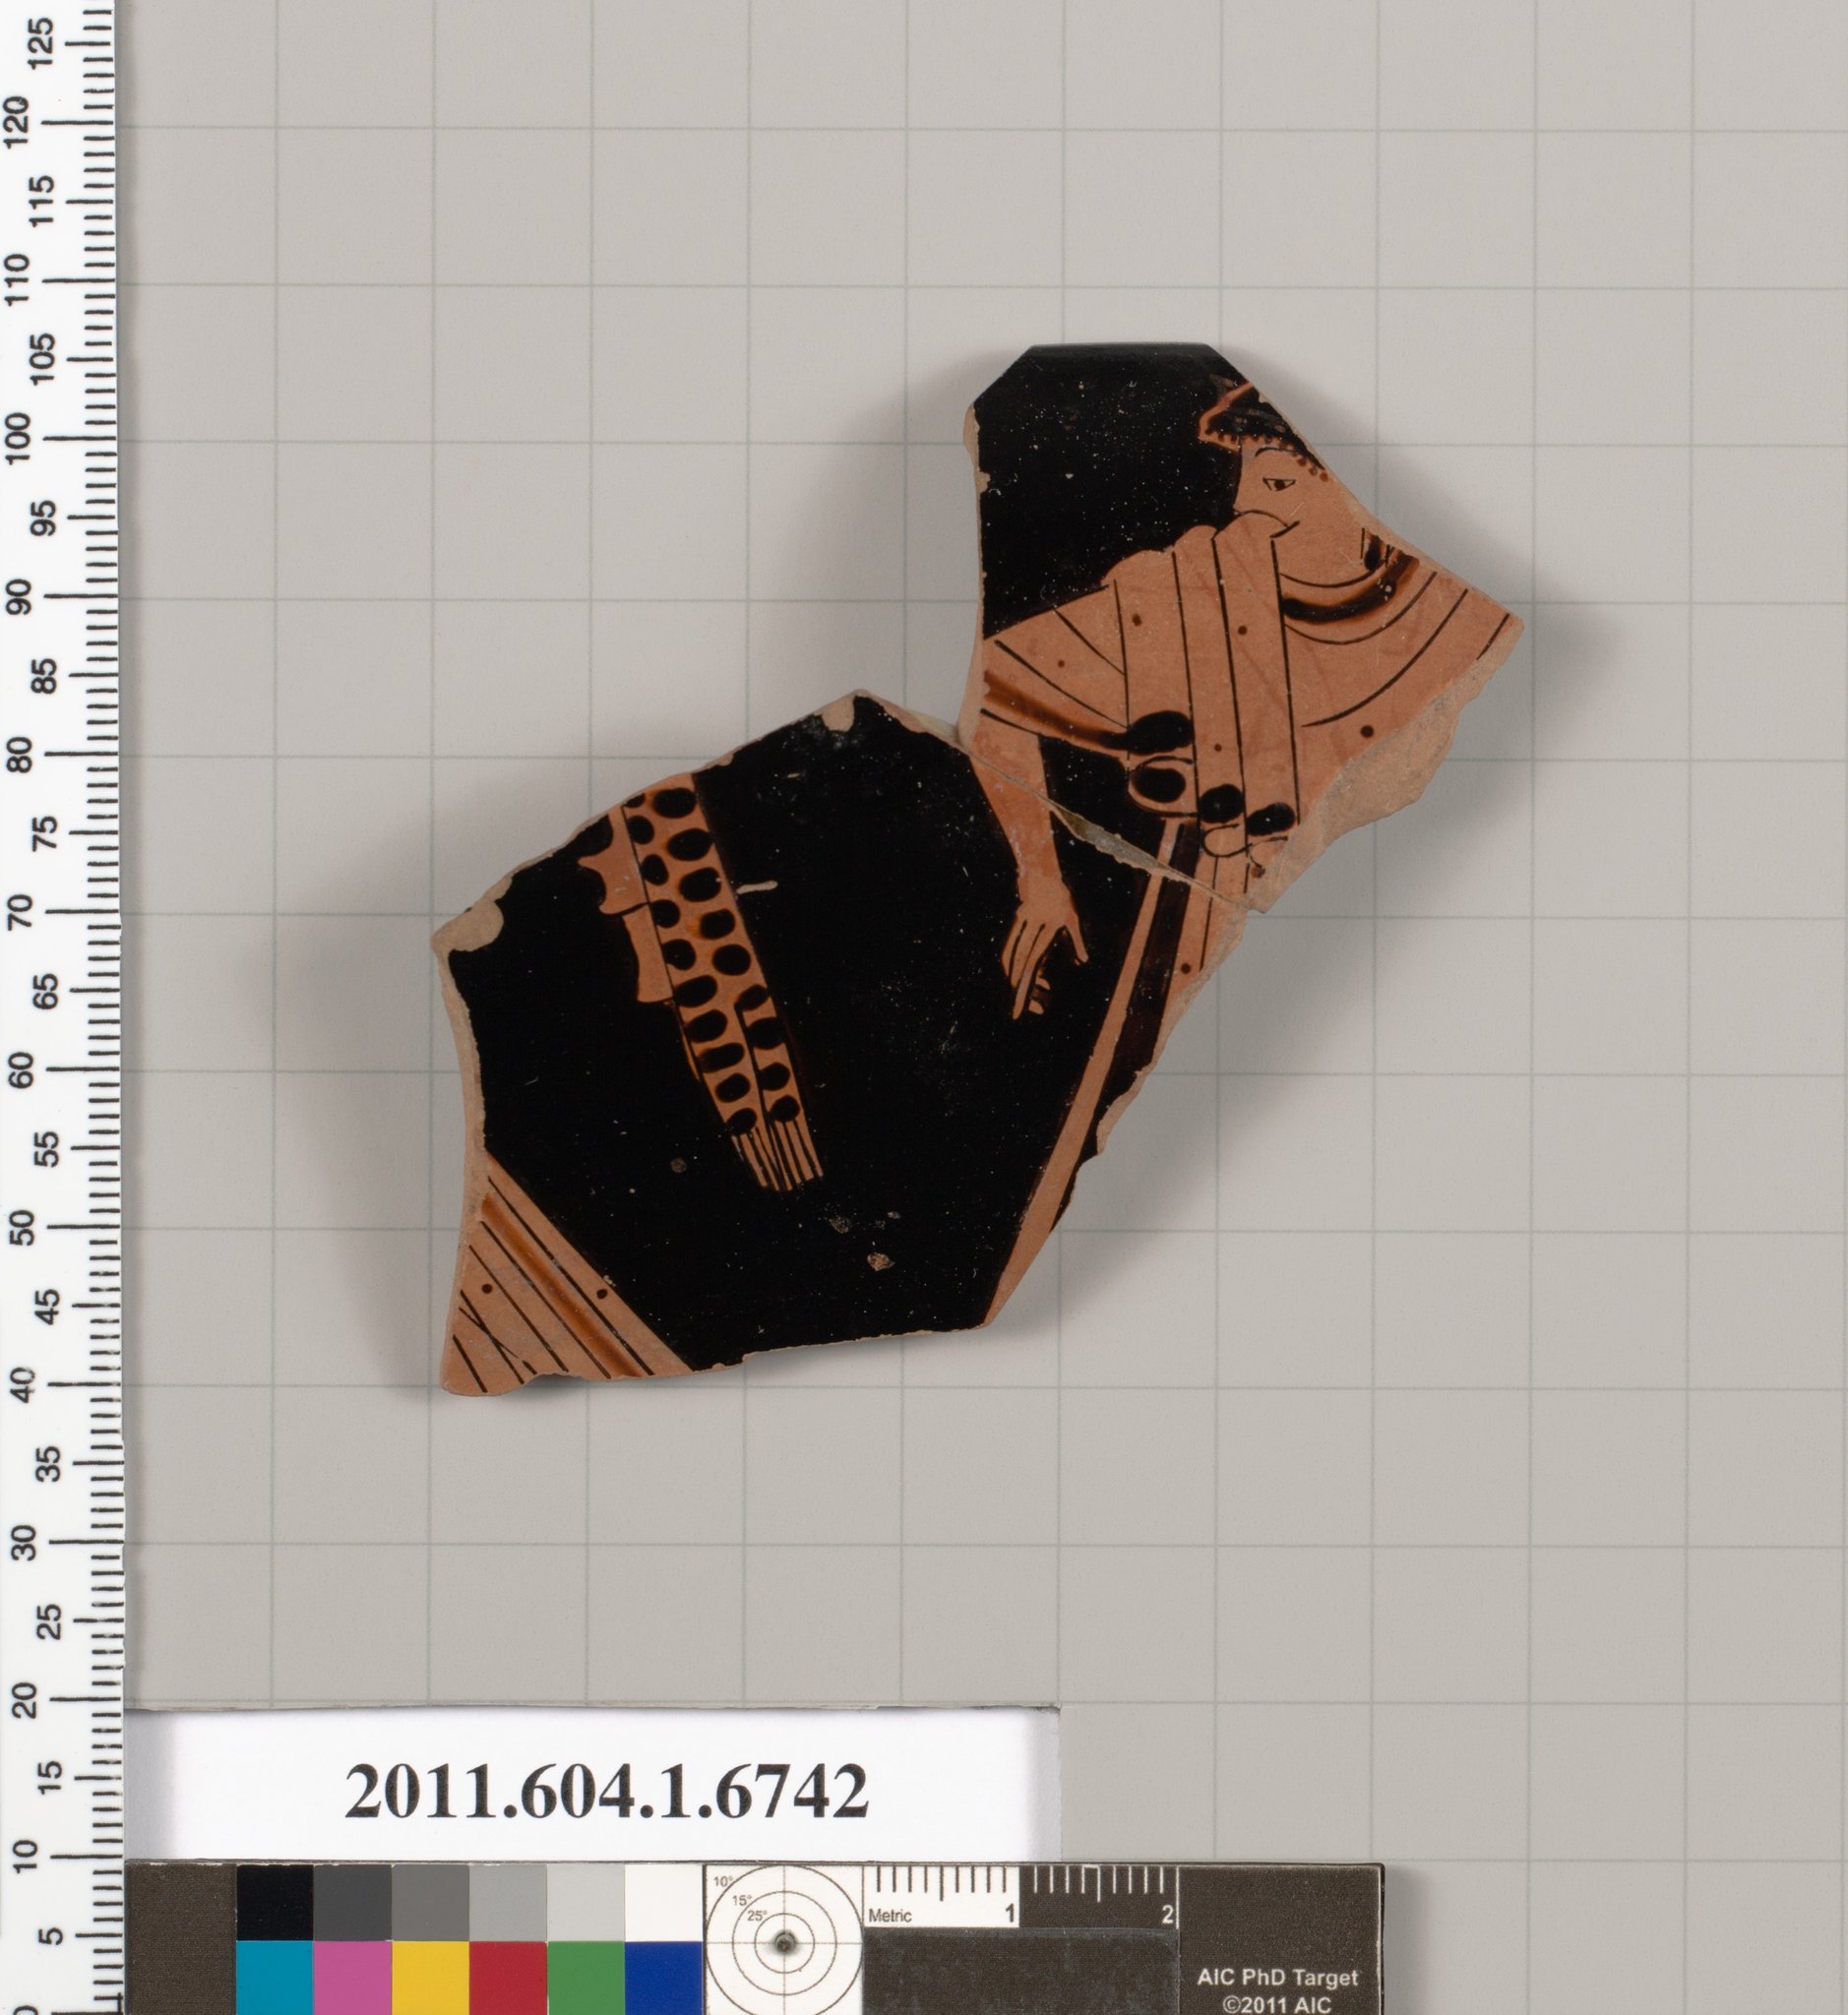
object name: kylix fragment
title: Terracotta rim fragment of a kylix (drinking cup)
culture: greek, attic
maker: briseis painter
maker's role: artist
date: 490-470 BCE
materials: terracotta